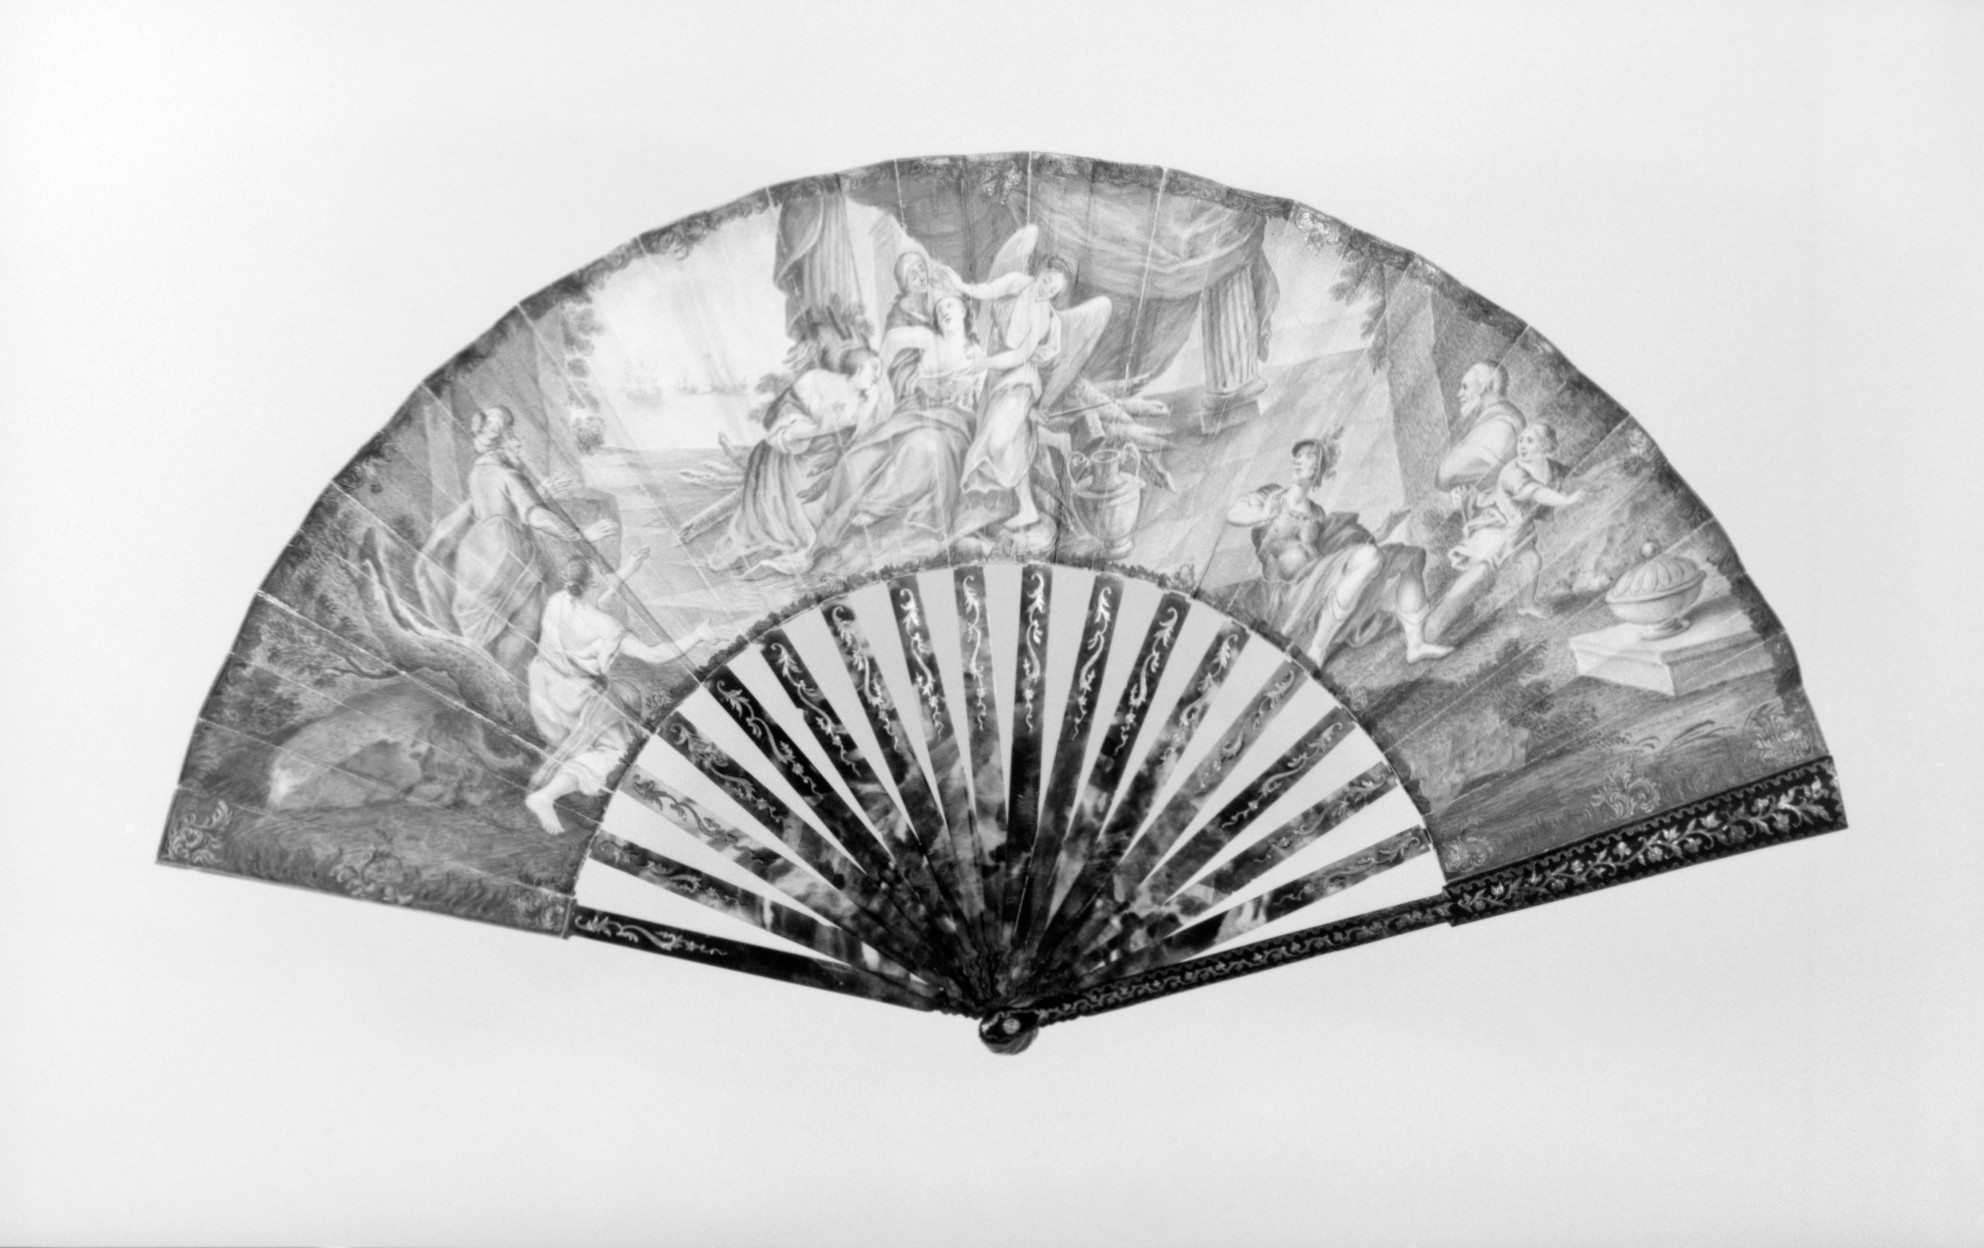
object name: fan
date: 1750-1800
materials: parchment, shell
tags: men,women